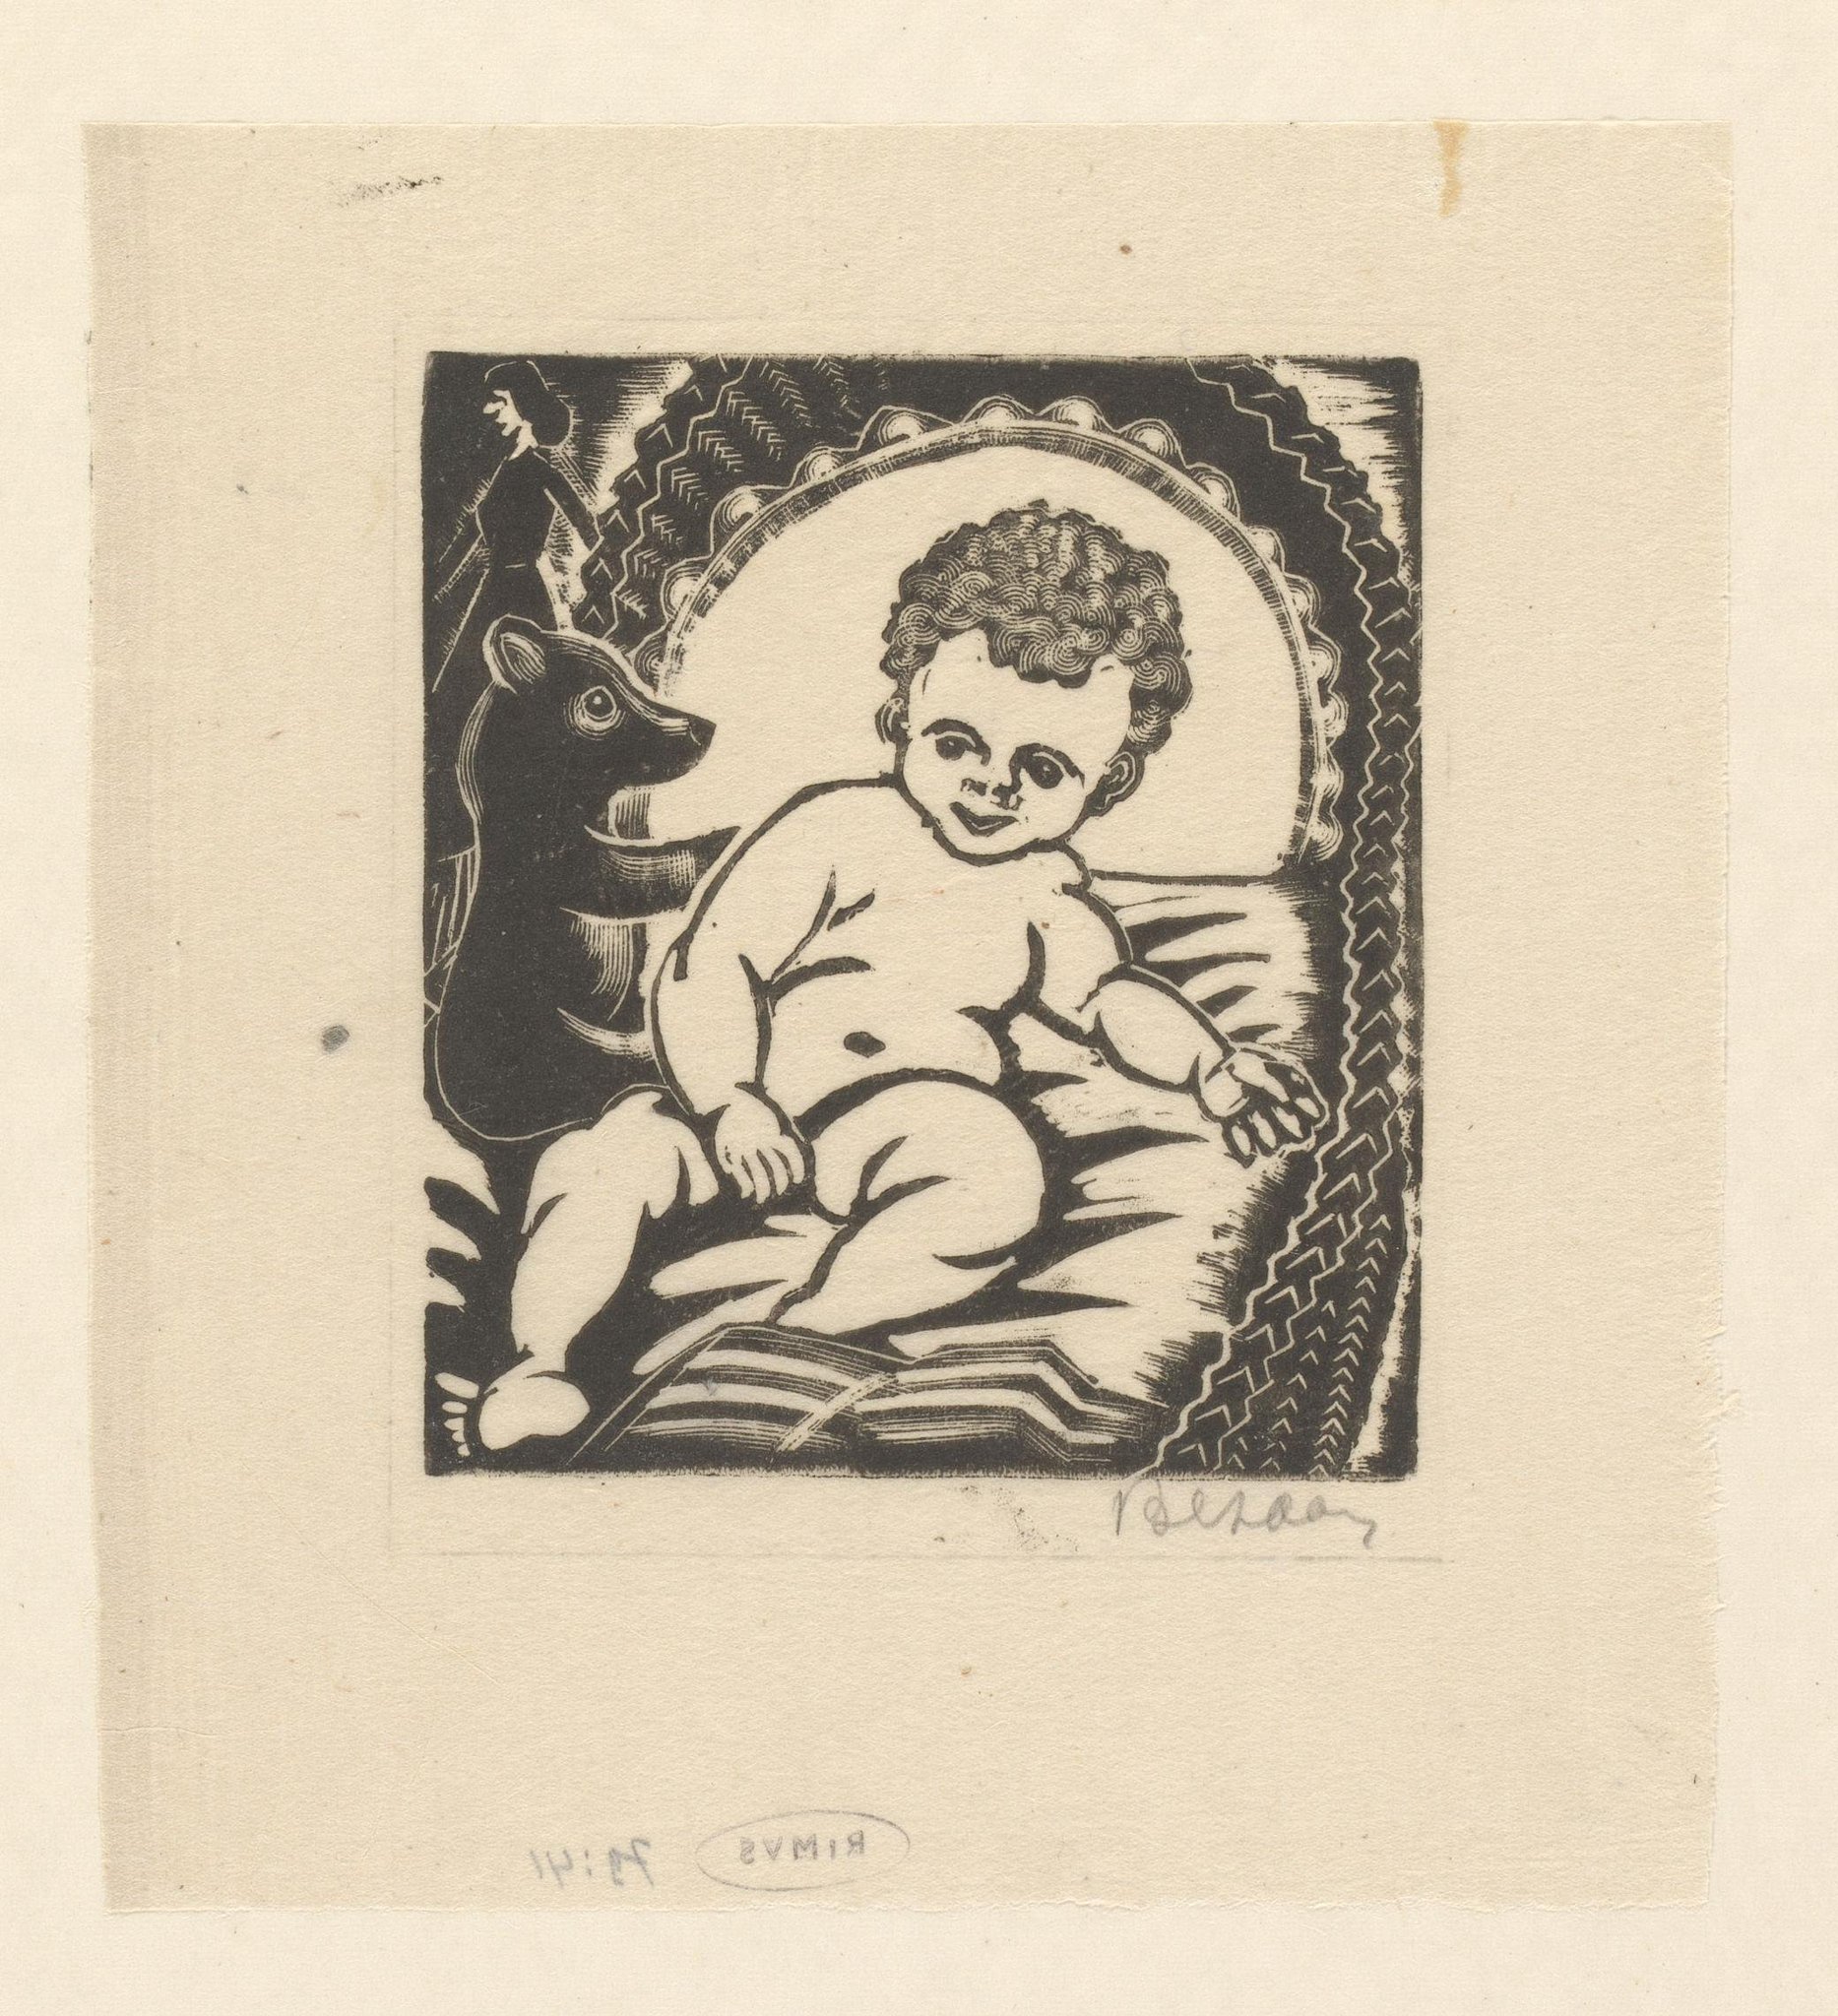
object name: print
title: Baby met een beer in een wieg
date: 1941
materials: paper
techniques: engraving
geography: putten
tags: (playing with) toy animals, cradle, crib, infant, baby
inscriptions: collector's mark: Lugt 2228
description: Prent gebruikt voor: Hattum, Jac. van. Van Odrimond, Millimas en anderen. Putten: D.J. Terwee, [1941].